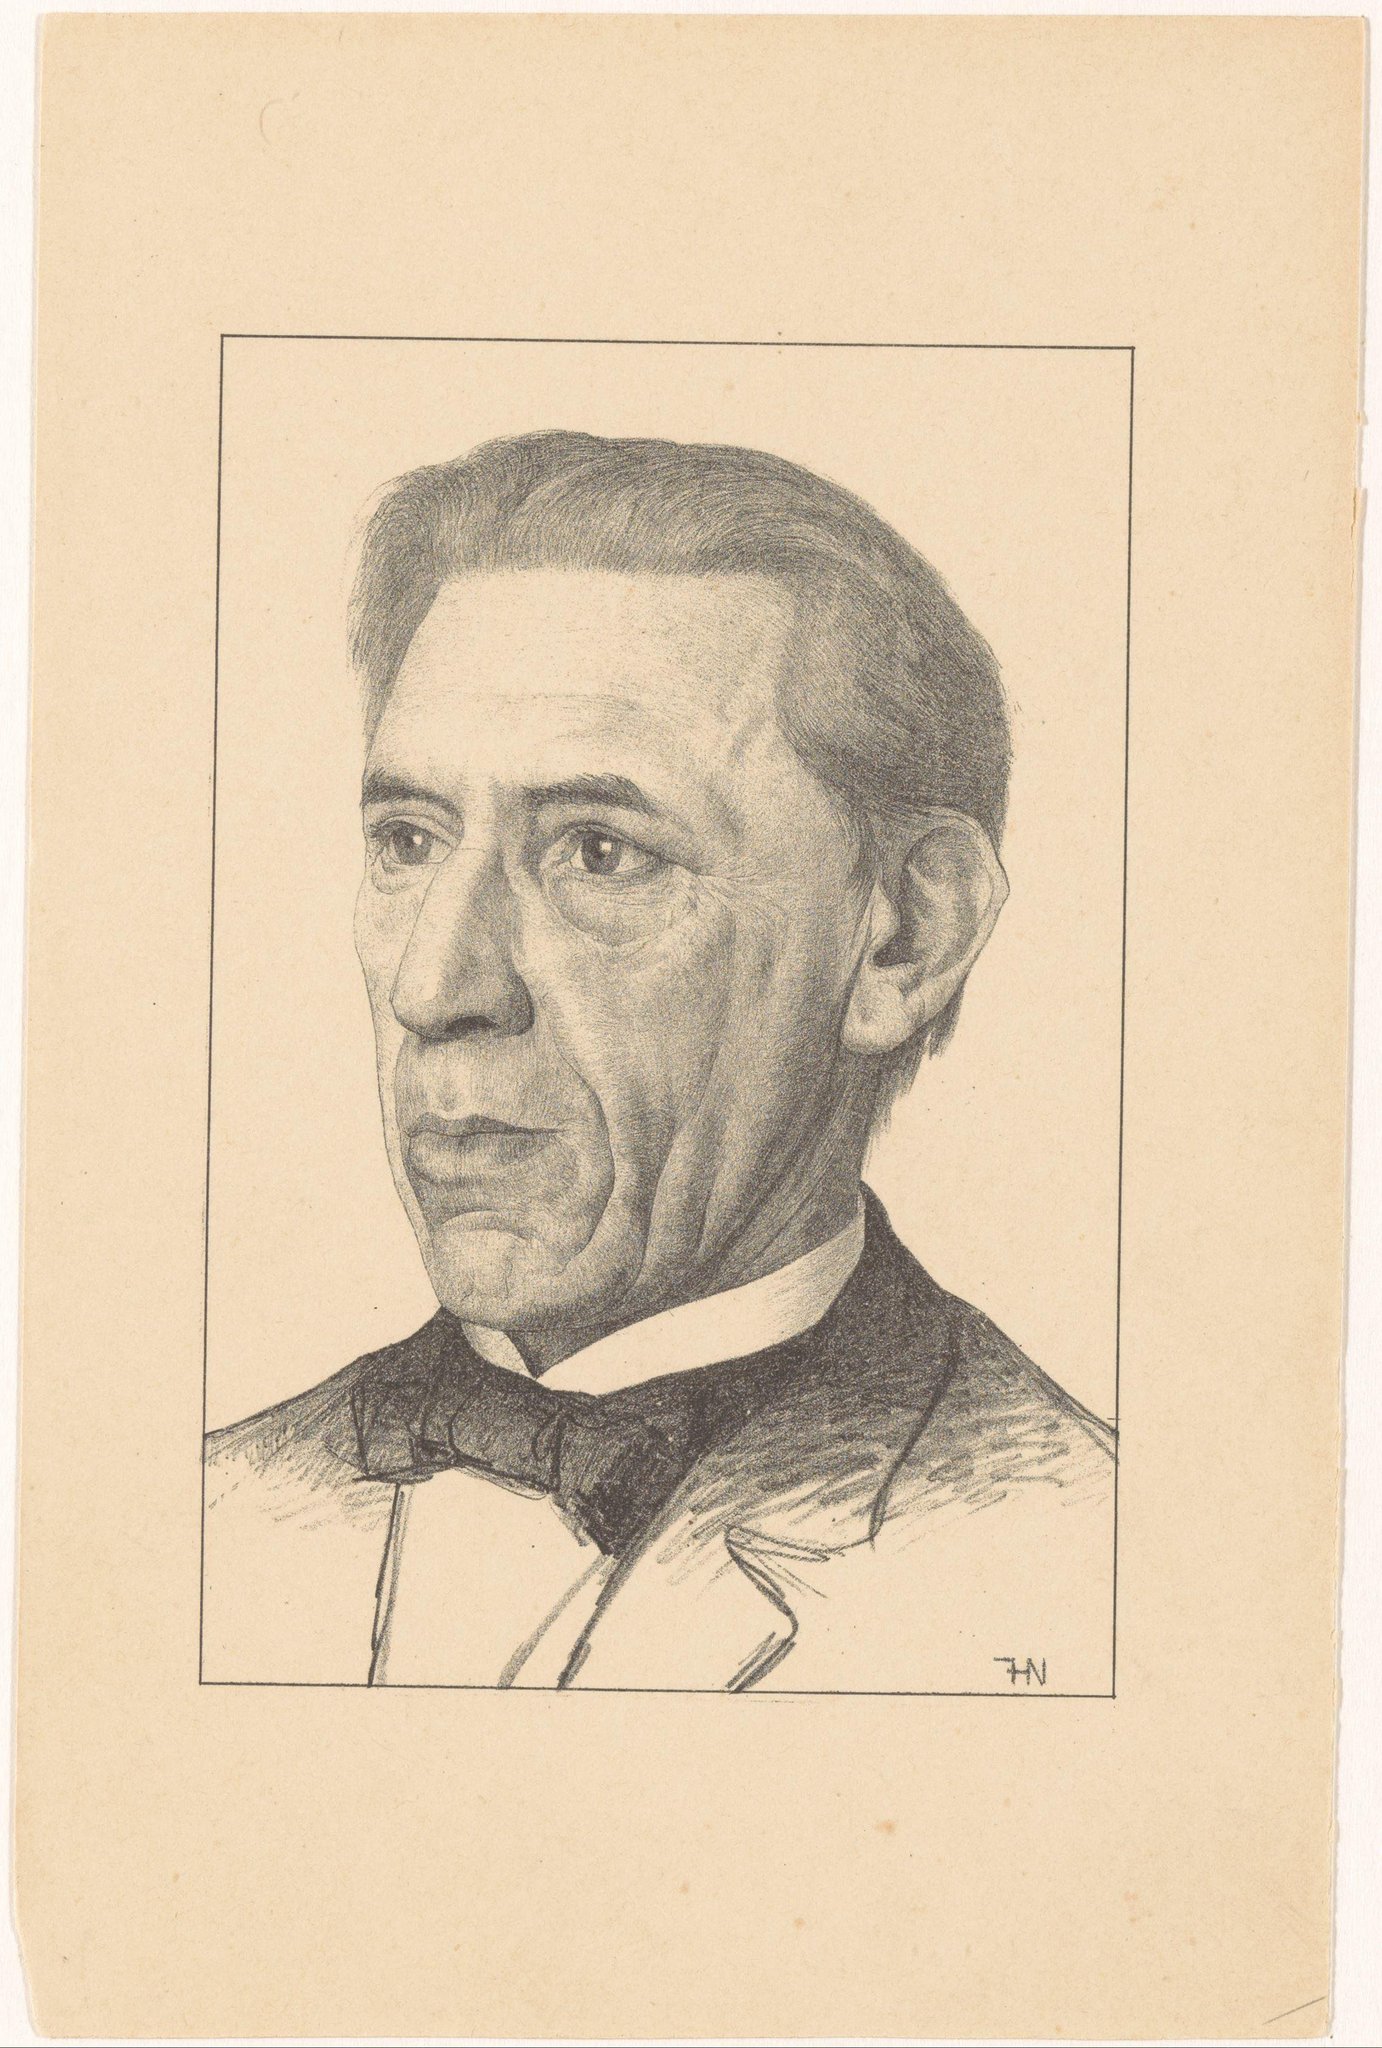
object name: print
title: Portret van Herman Thomas Karsten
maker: ferdinand hart nibbrig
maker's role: draughtsman, painter, print maker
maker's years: 1866-1915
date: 1876-1904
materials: paper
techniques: lithograph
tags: historical persons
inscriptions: collector's mark: Lugt 2228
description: Een portret van hoogleraar Herman Thomas Karsten.